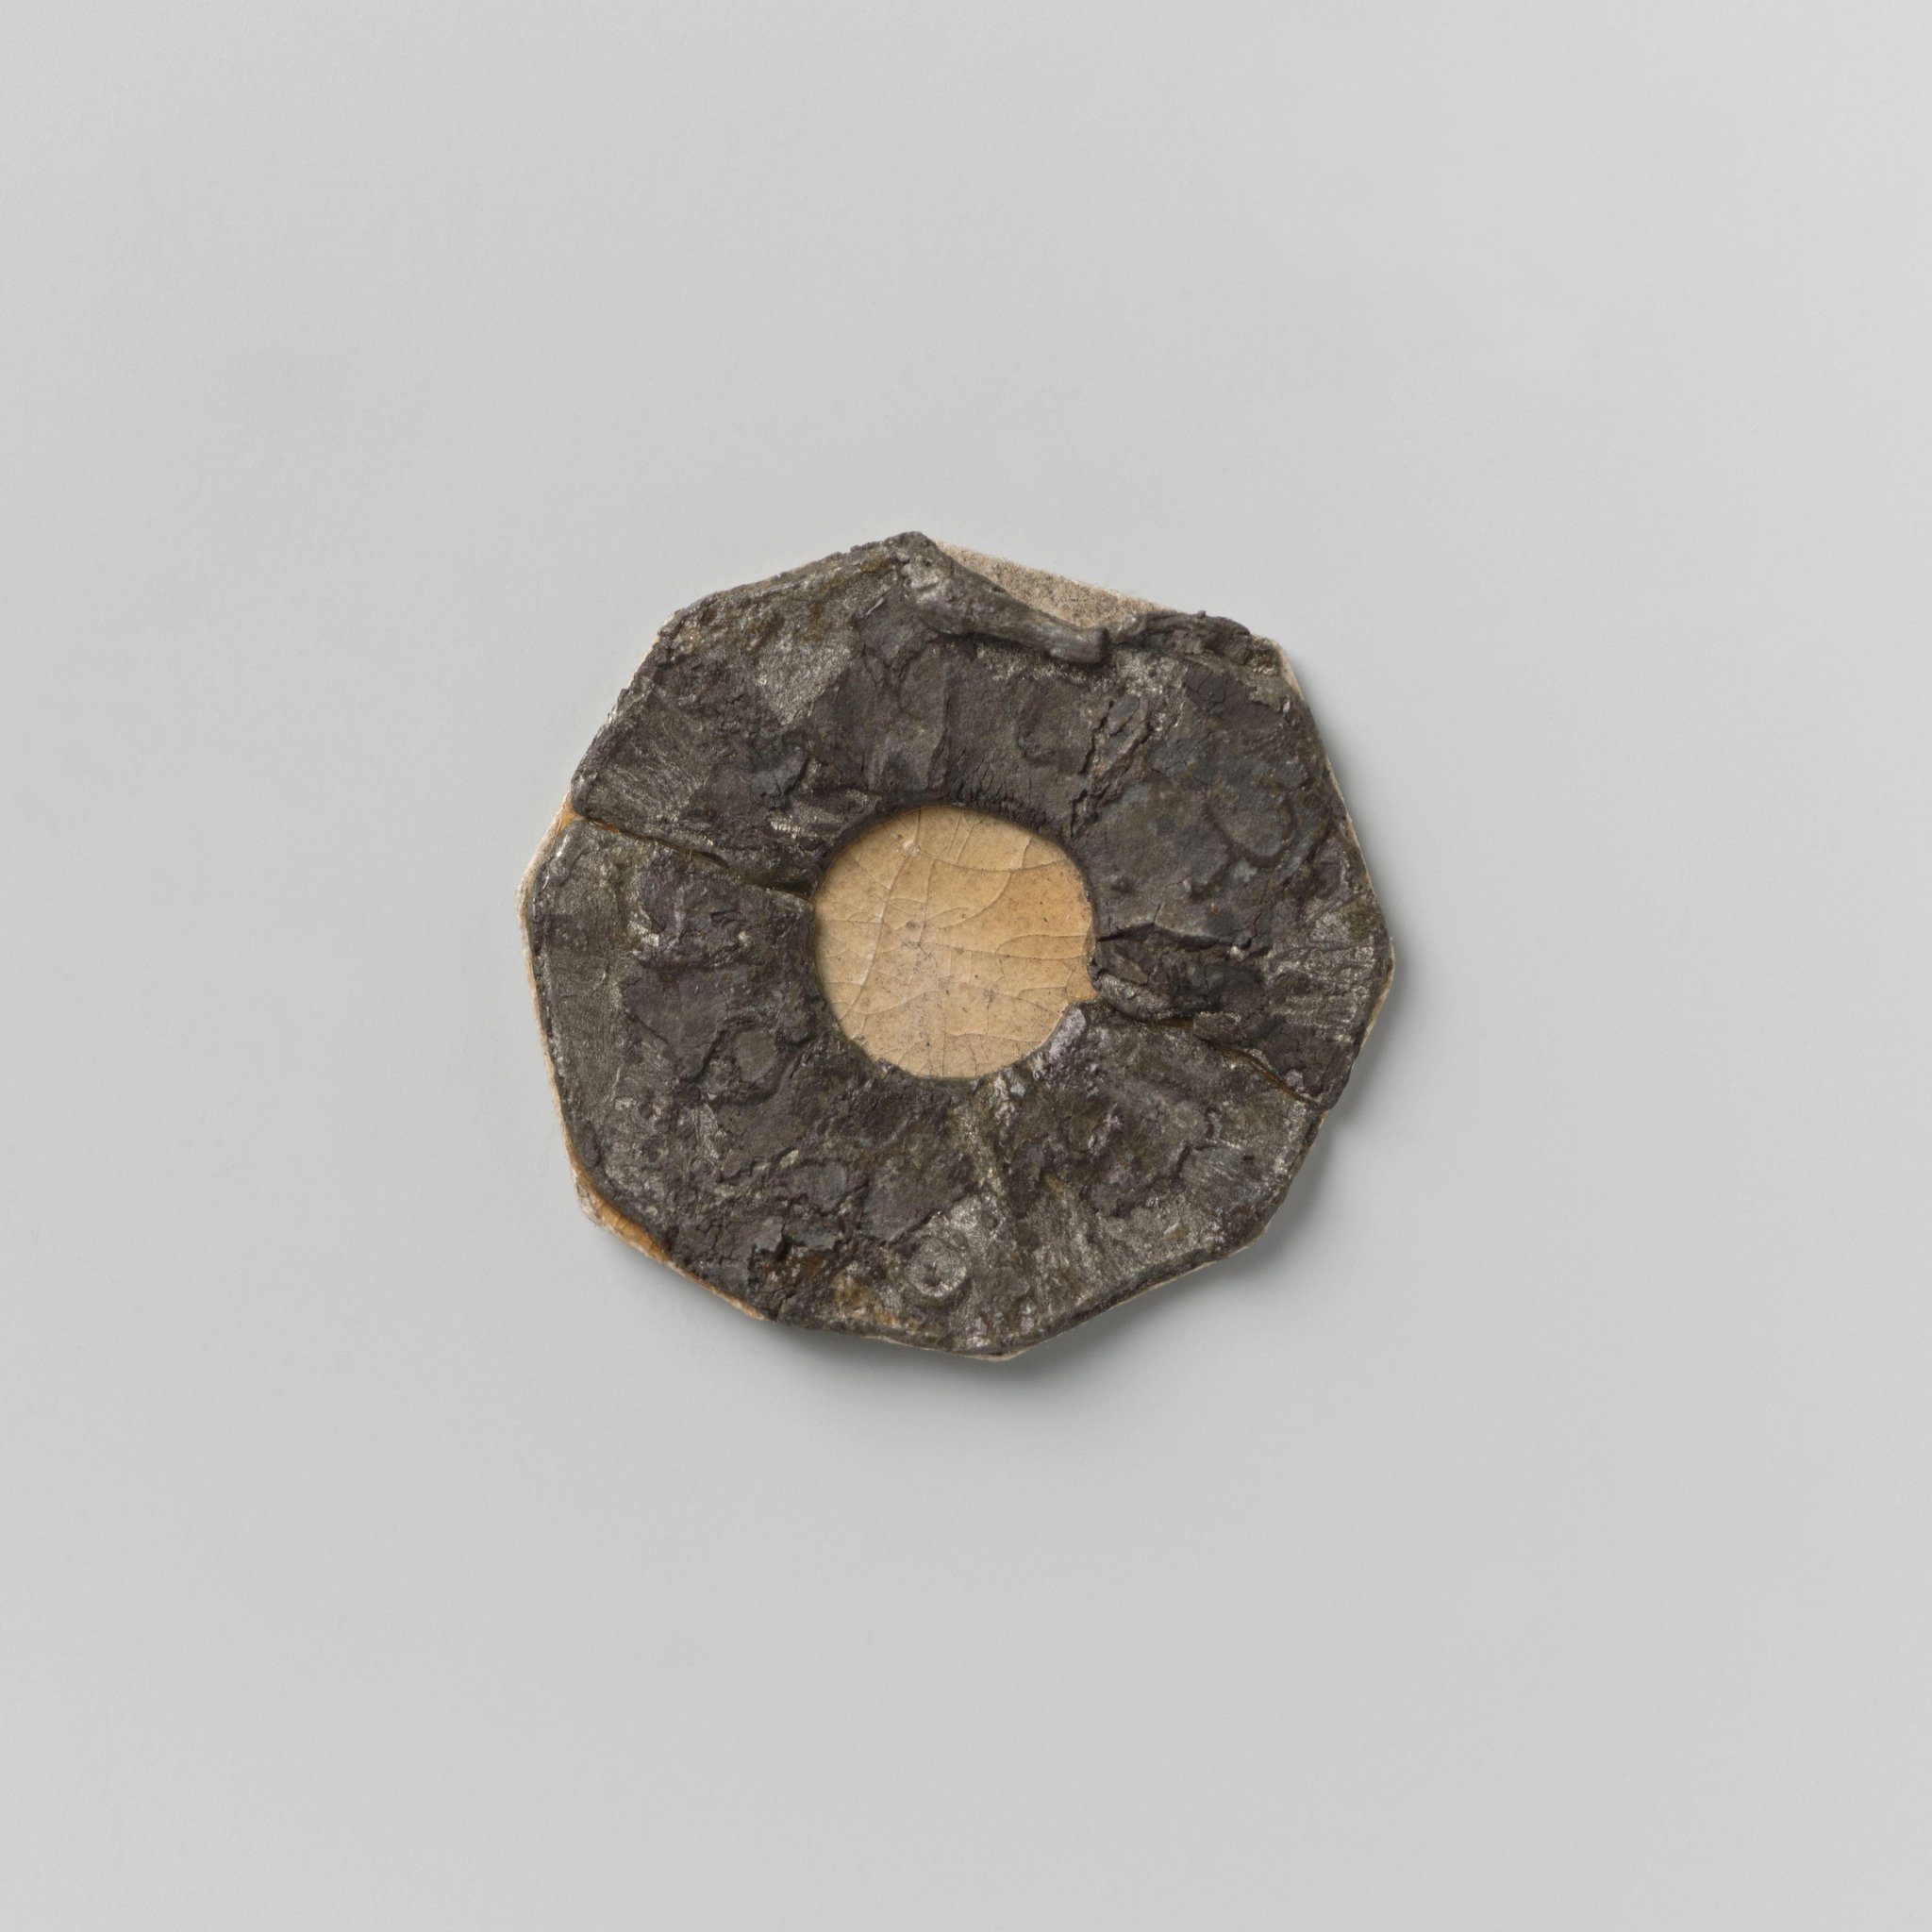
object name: coin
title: Palembang, Sumatra, sultan Mamoed Bader ed-din II, pitji, A.H. 1219 (1804)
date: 1804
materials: tin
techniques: casting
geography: palembang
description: Tinnen achthoekige munt. Voorzijde: omschrift in Arabische lettertekens, waartussen jaartal in Islamitische jaartelling. Keerzijde, glad. In het midden rond gat.